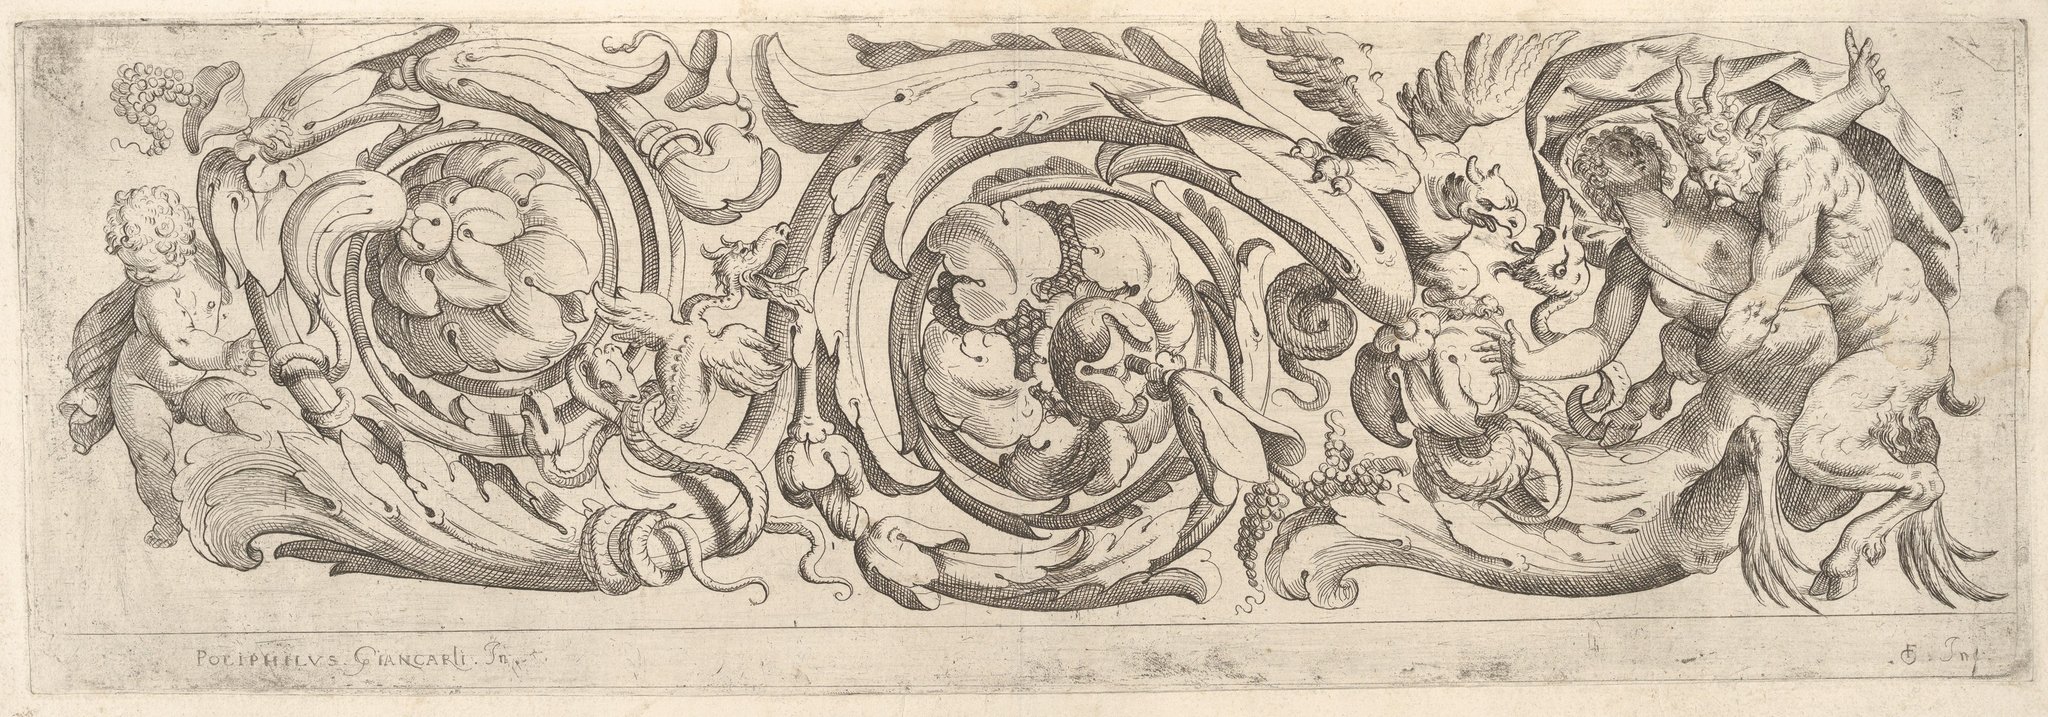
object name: collection ornament architecture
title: Disegni Varij di Polifilo Zancarli (Friezes)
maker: polifilo giancarli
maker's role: artist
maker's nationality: italian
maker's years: 1600-1625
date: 1625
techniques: etching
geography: italy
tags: dragons,satyrs